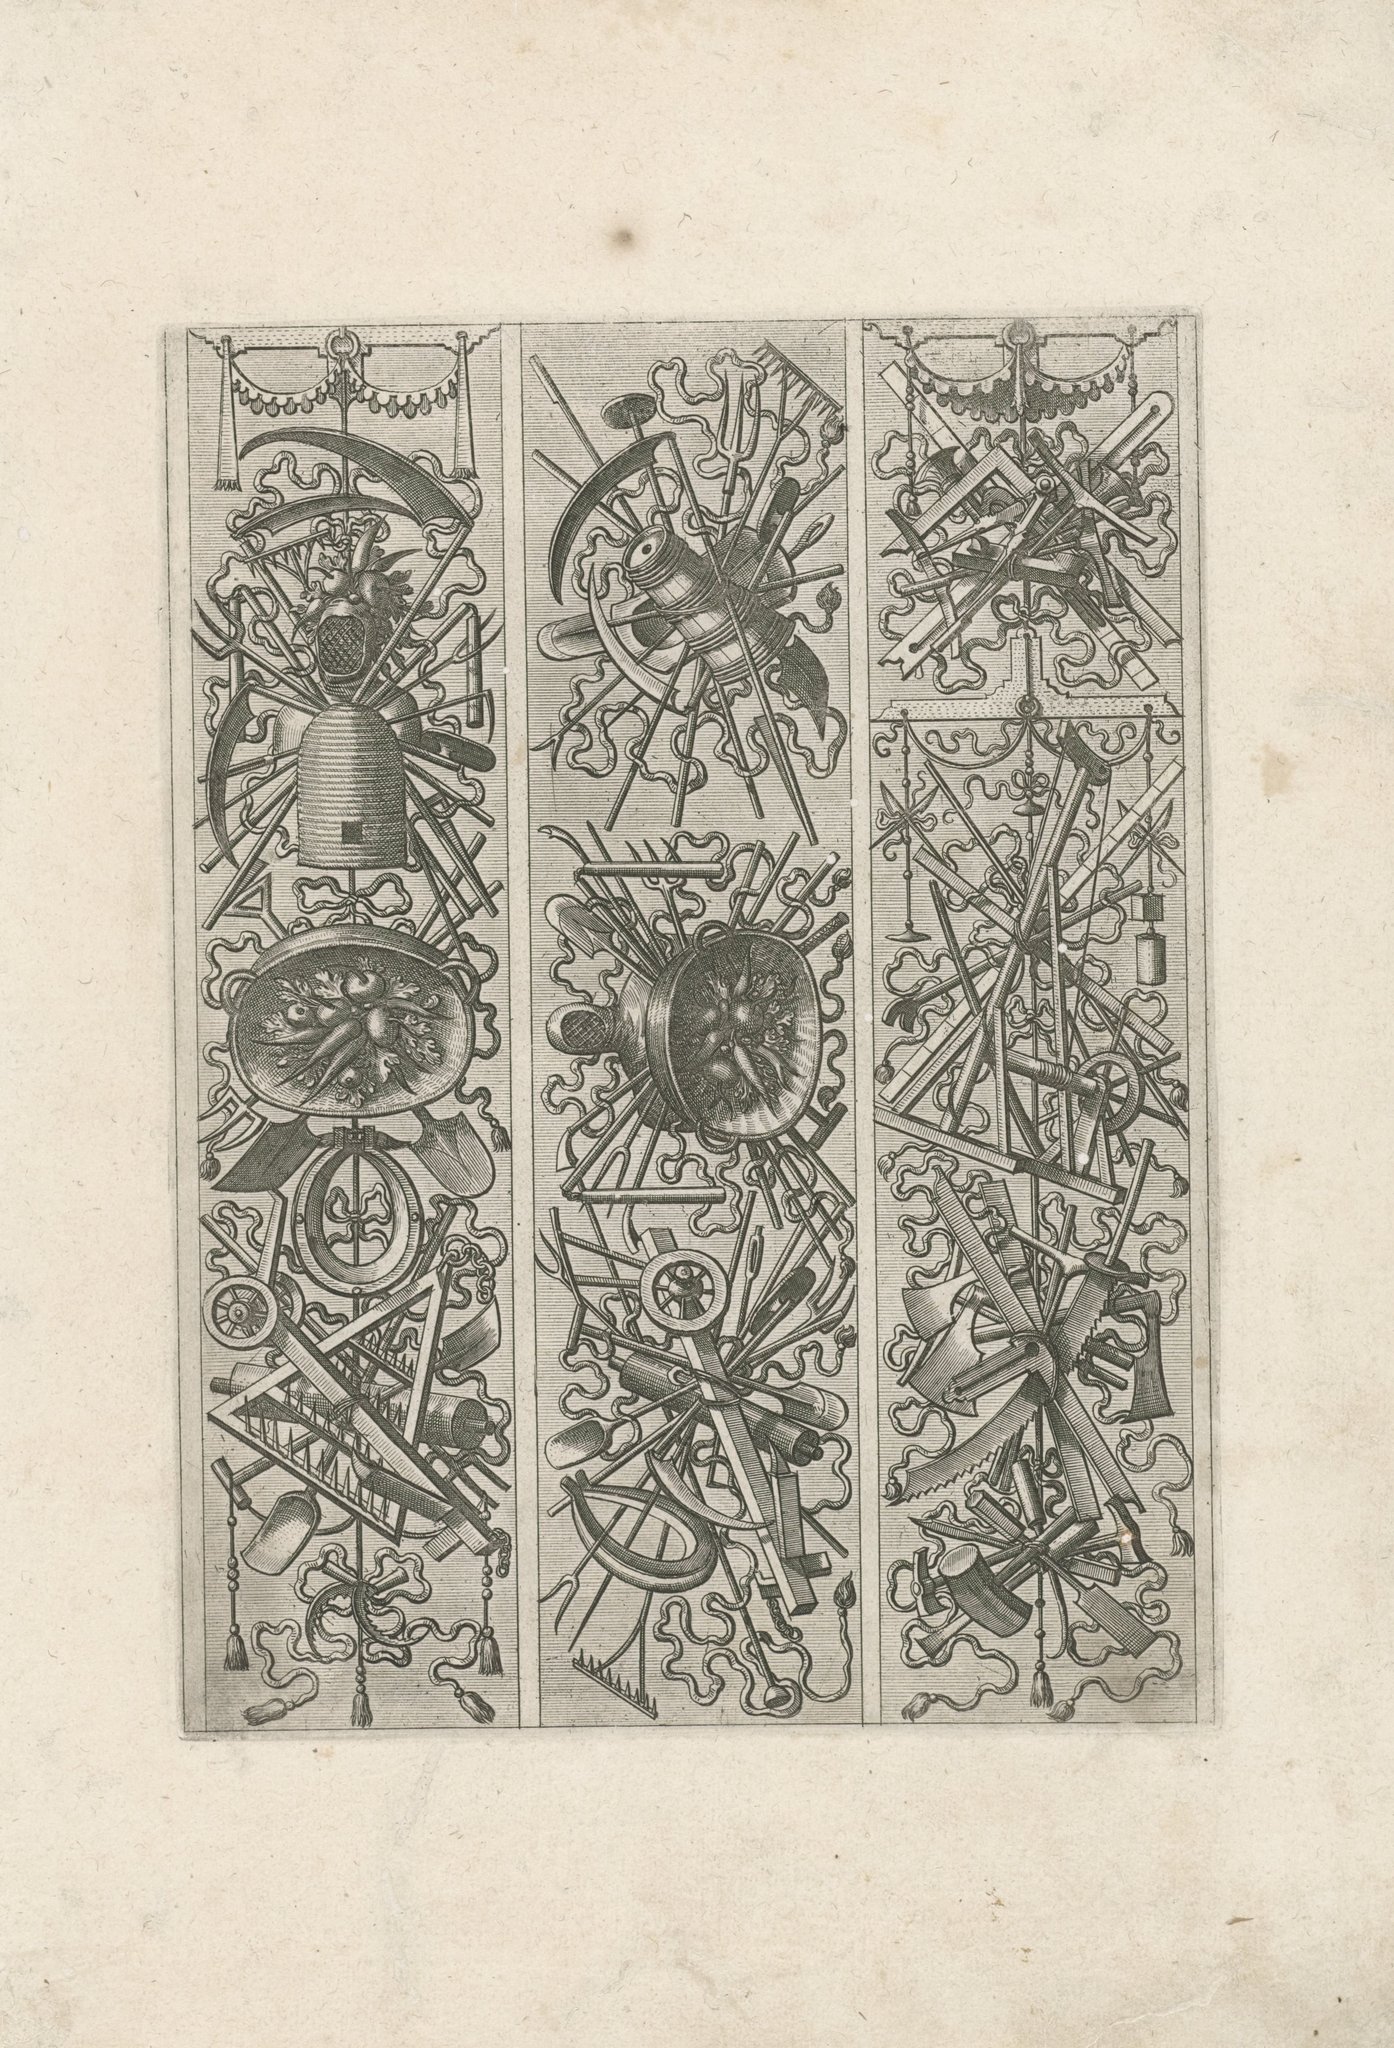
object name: print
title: Panoplia sev armamentarium…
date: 1572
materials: paper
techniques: etching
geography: netherlands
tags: tools and machines ~ building, trophy, i.e.: decorative arrangement of symbolic or typical objects ~ ornament, crafts and industries (+ tools and appliances ~ crafts, industries, agriculture)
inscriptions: : ‘.’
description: Drie verticale trofeeën: twee met landbouwwerktuigen en een met bouwgereedschap. Uit serie, bestaande uit een titelblad en 16 bladen.